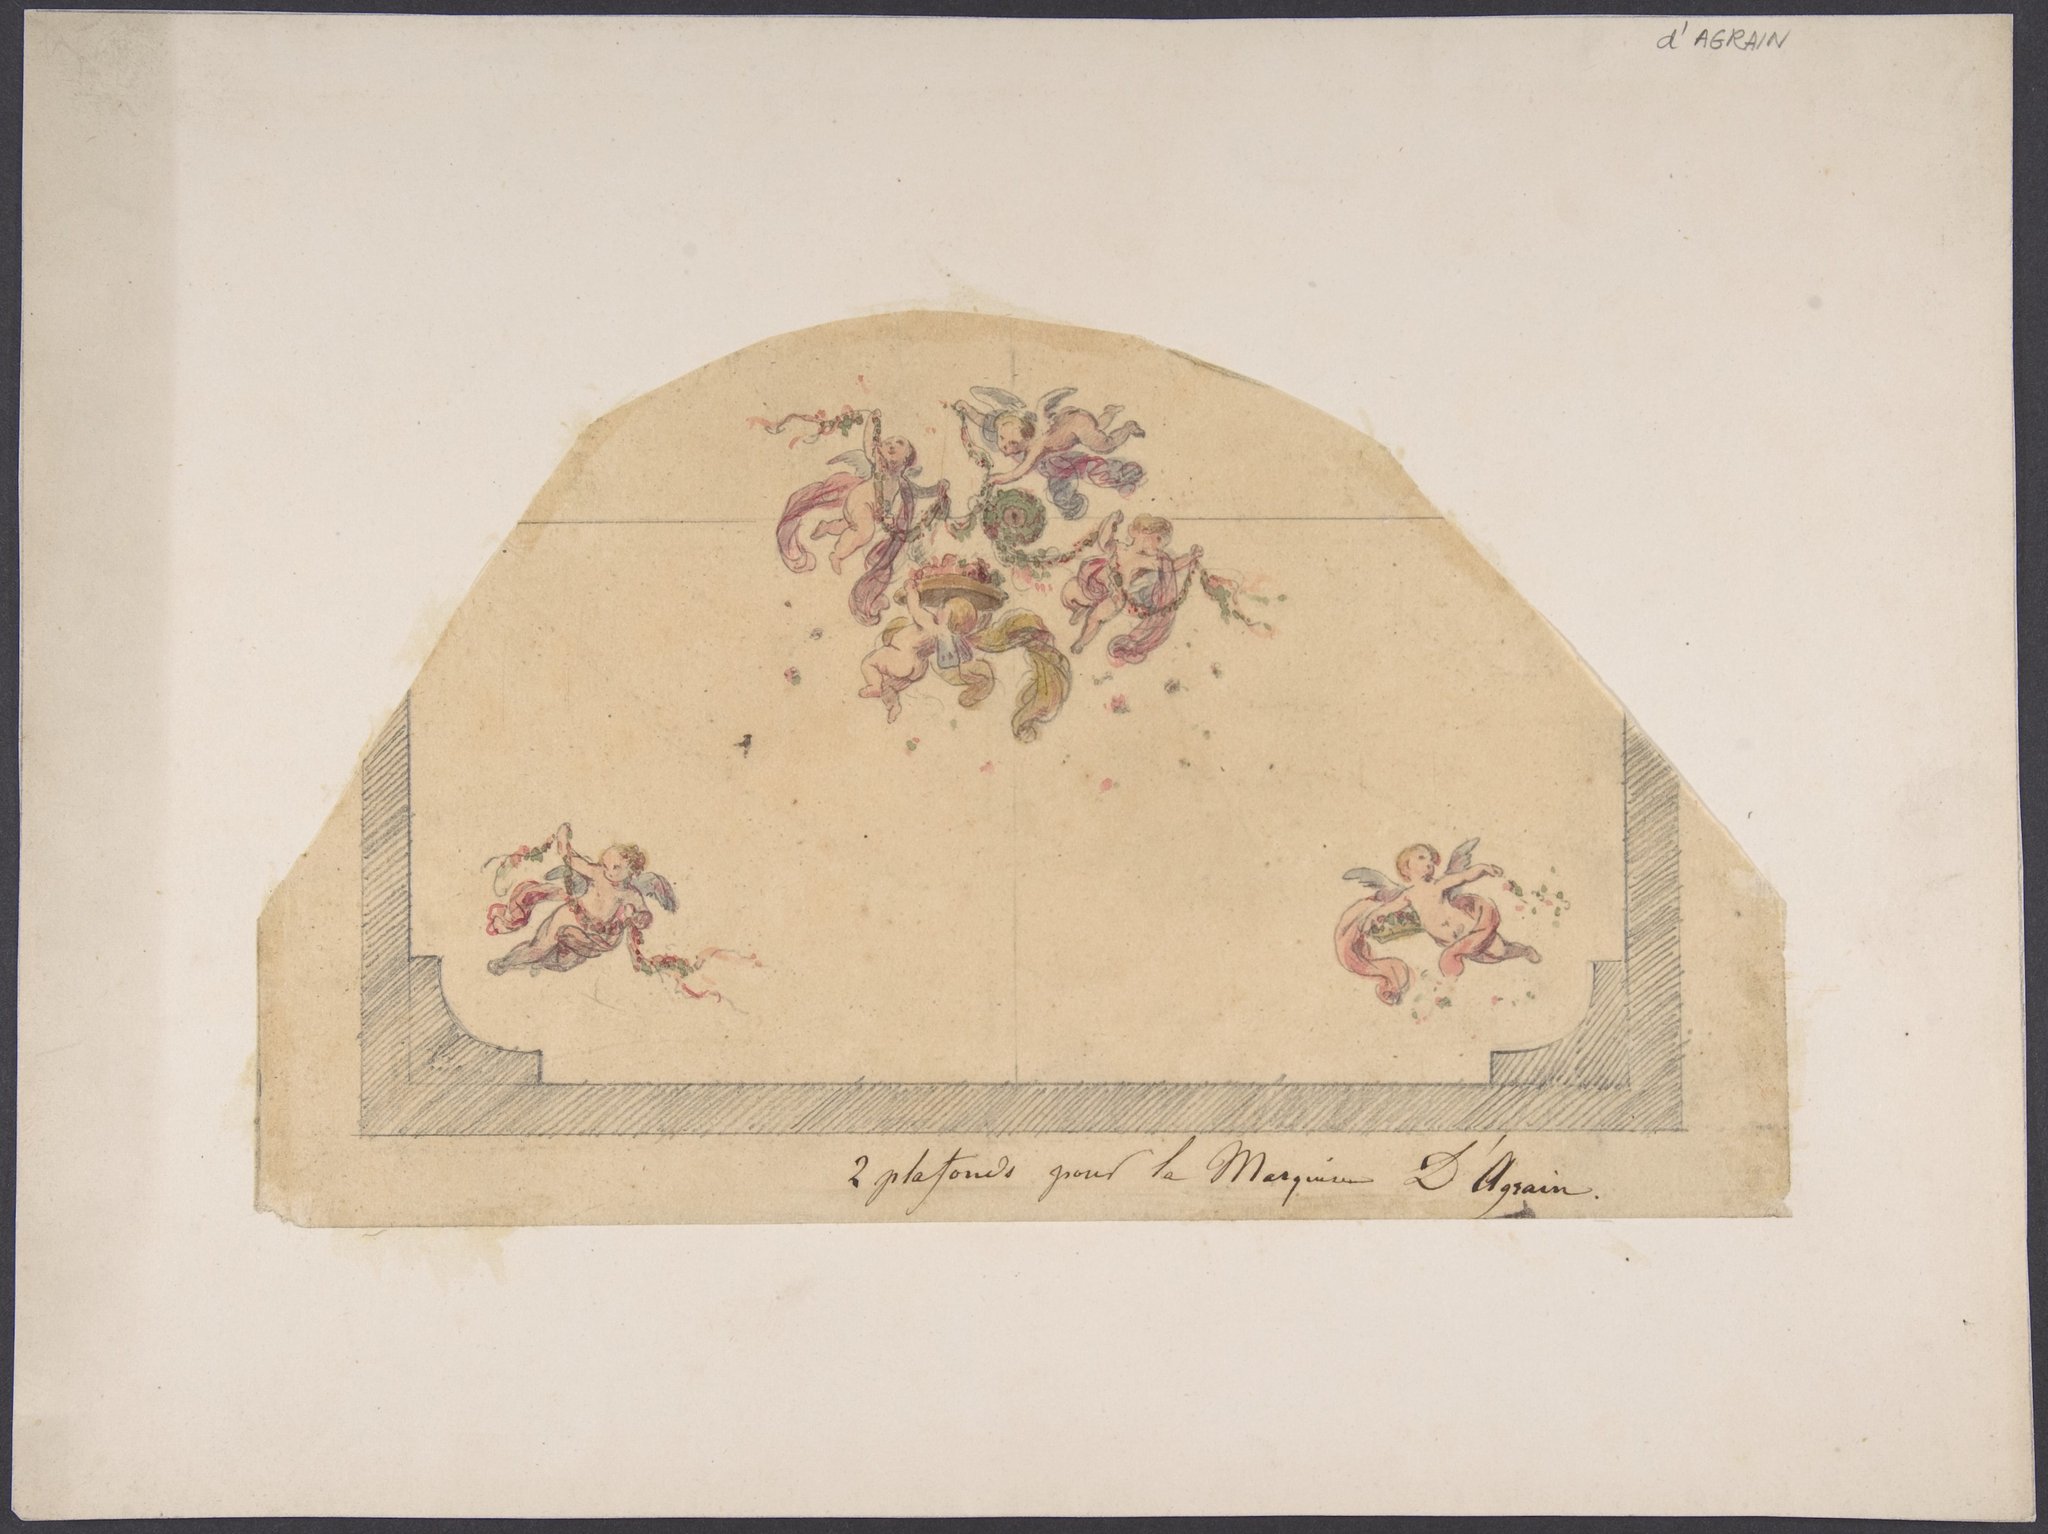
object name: drawing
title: Design for Ceiling with Cherubs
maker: jules-edmond-charles lachaise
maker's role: artist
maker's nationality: french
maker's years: 1897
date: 1851-1900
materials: gouache, graphite, watercolor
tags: flowers